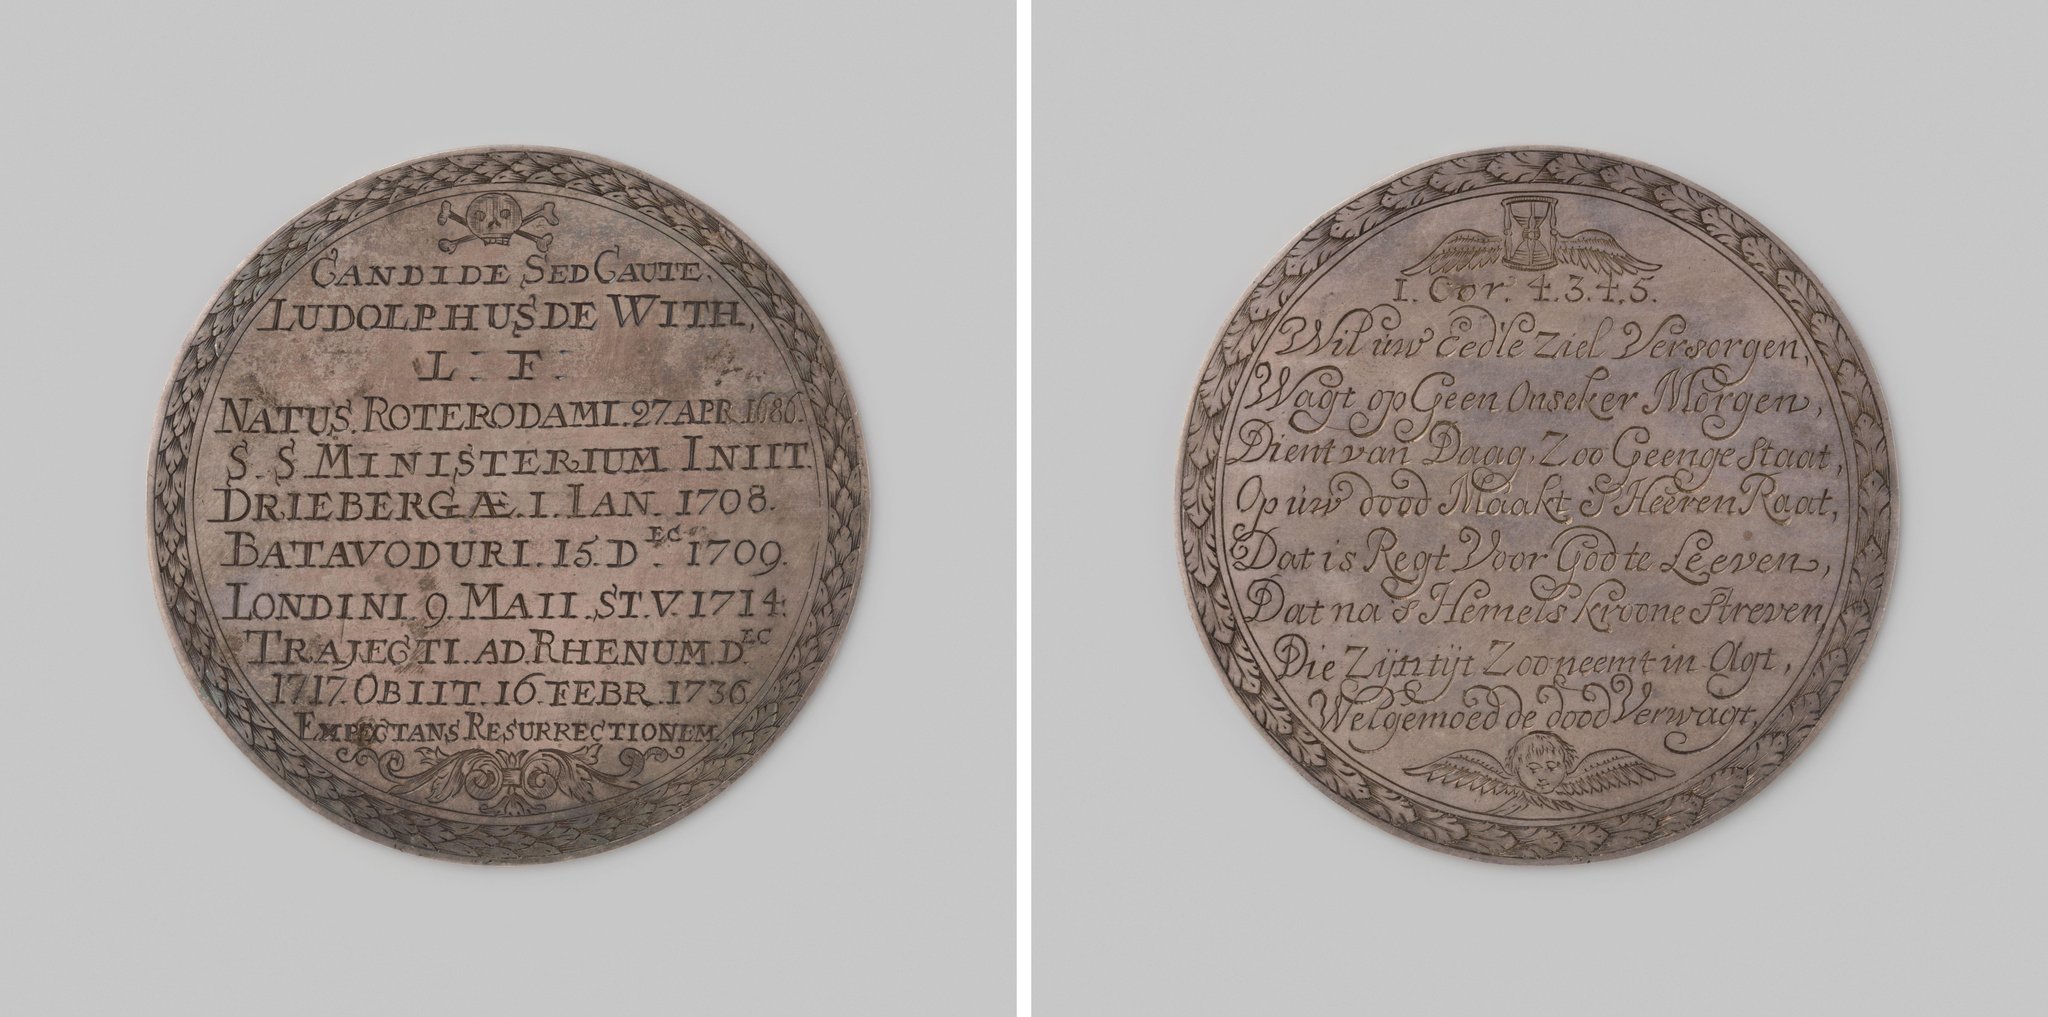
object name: history medal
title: Overlijden van predikant Ludolphus de With 1736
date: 1736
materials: silver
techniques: engraving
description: Forse beiderzijds gegraveerde ronde plaat zilver, op de voorzijde onder een doodshoofd elf regels tekst en een bladornament binnen een bladerkrans, op de keerzijde onder een zandloper negen regels tekst en een engelenkopje binnen een bladerkrans.